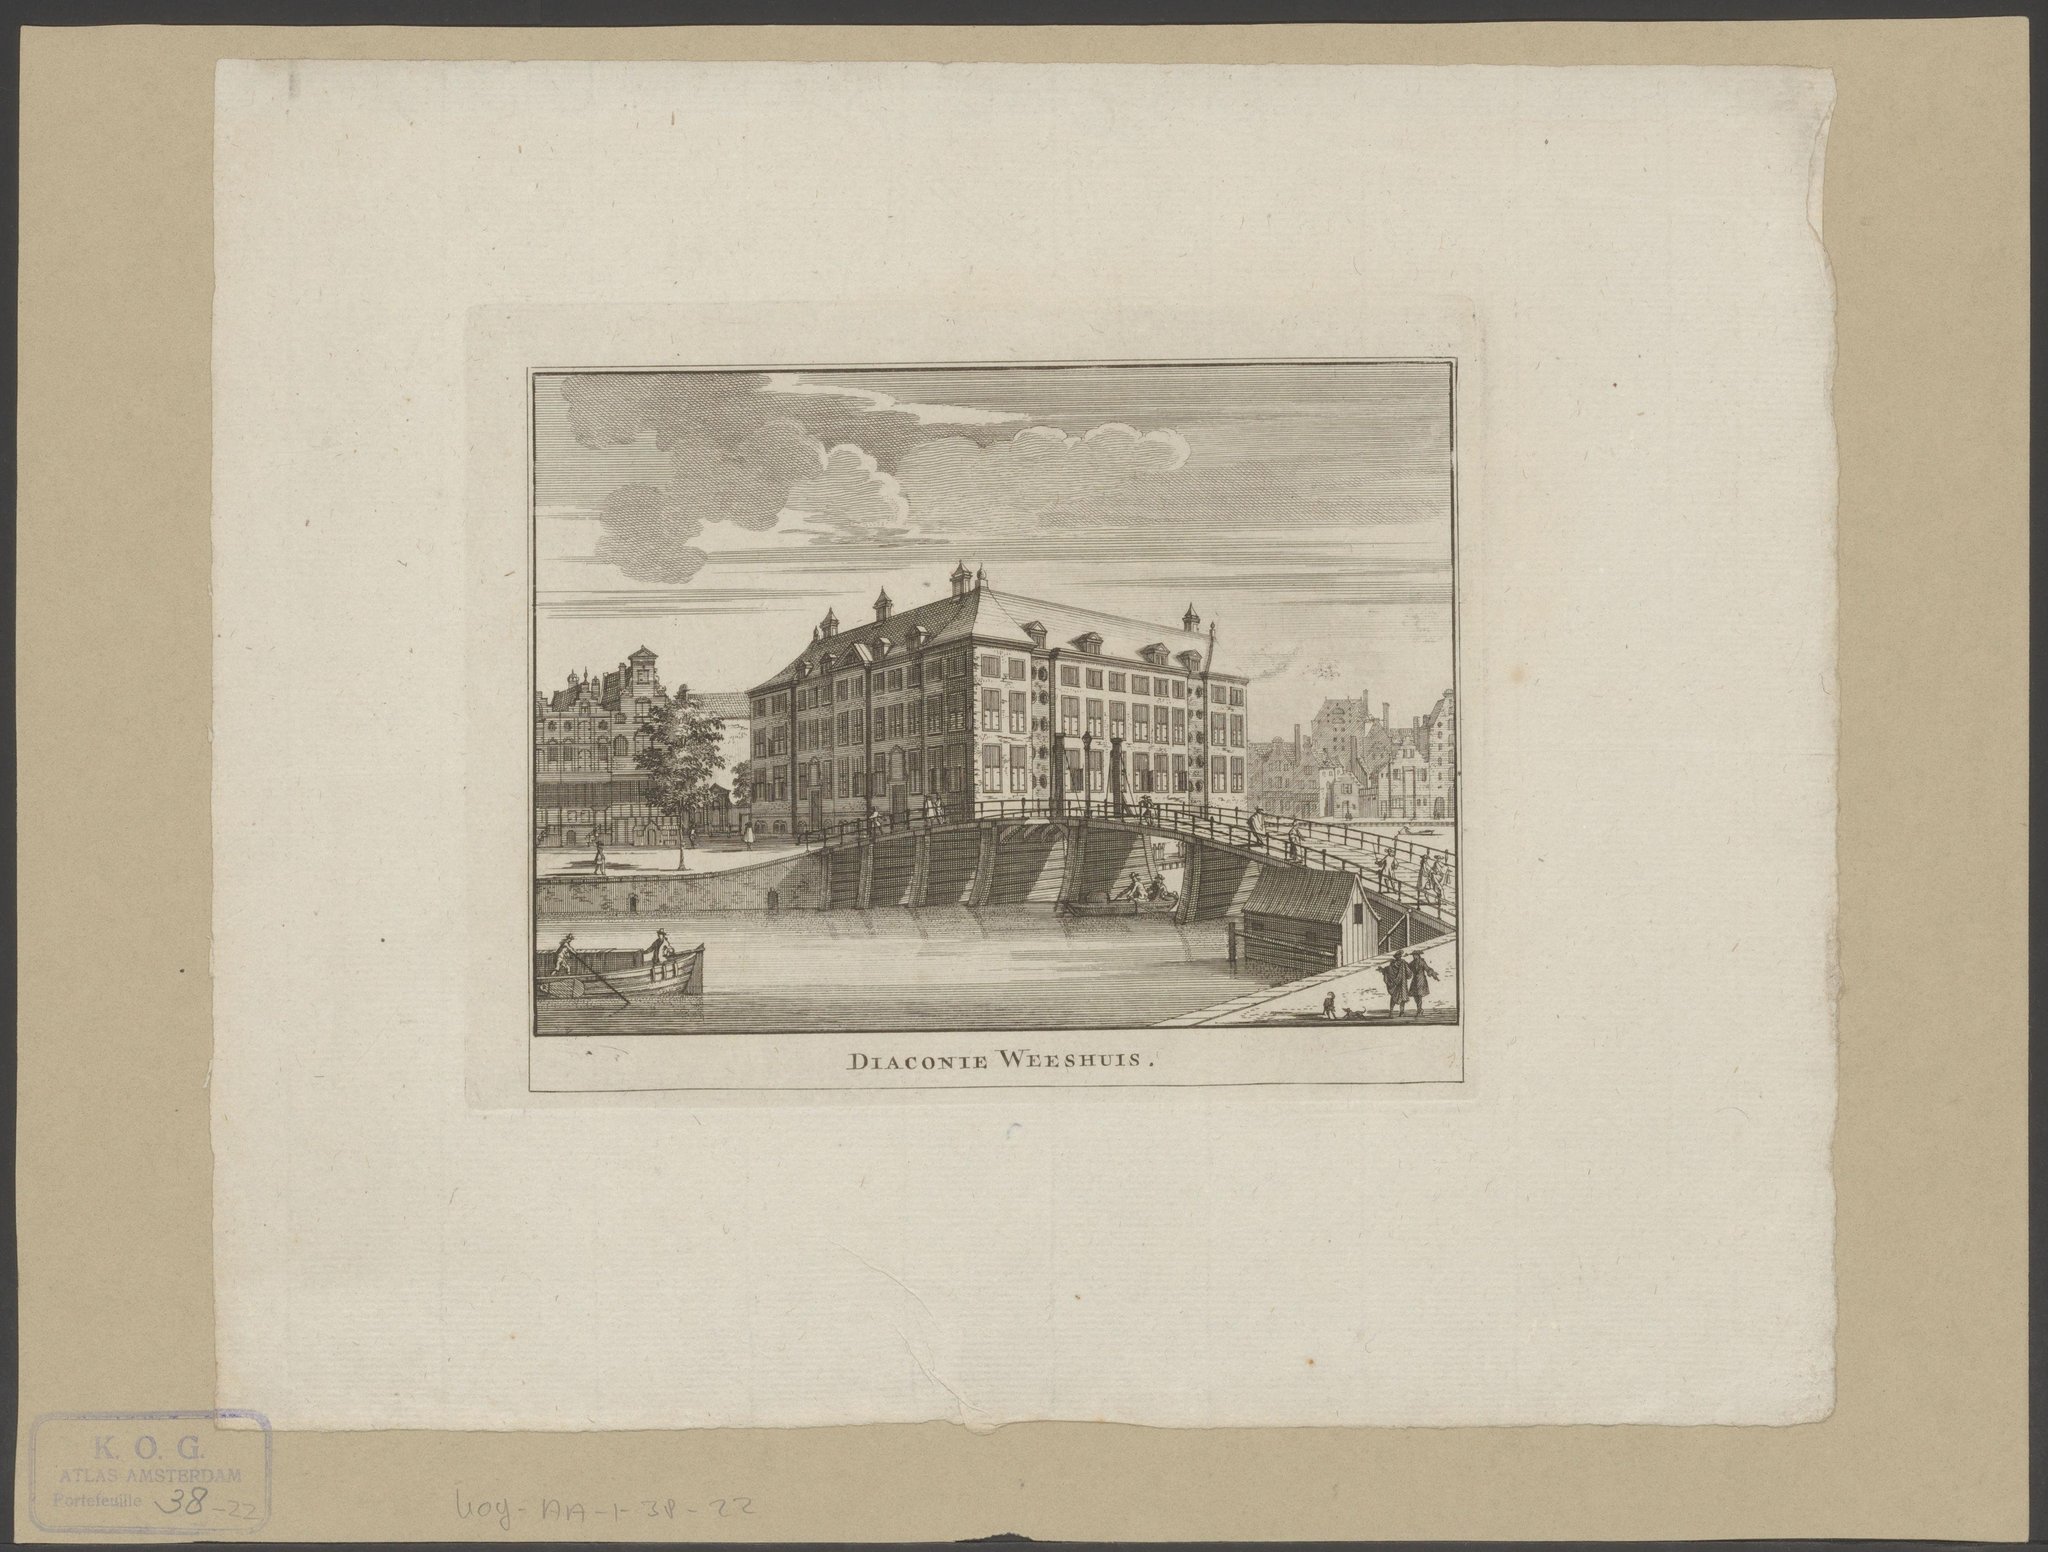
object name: print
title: Diaconie Weeshuis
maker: Anonymous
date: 1751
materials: paper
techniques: engraving, etching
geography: northern netherlands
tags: bridge in city across river, canal, etc. (+ city(-scape) with figures, staffage), orphanage, canals, waters (in city) (+ city(-scape) with figures, staffage)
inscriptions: collector's mark: Lugt 1641b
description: Eerste staat van prent, genummerd 244, gebruikt in: Hoorn, Nicolaas ten. Wegwyzer door Amsterdam zynde eene beknopte verhandeling van desselfs eerste opkomst, vergrootingen, en teegenwoordigen staat (...). Amsterdam: Nicolaas ten Hoorn, 1713. En in: Hoorn, Nicolaas ten. Wegwyzer door Amsterdam zynde eene beknopte verhandeling van desselfs eerste opkomst, vergrootingen, en teegenwoordigen staat (...). Amsterdam: Nicolaas ten Hoorn, 1726. Tweede staat van prent, genummerd 259, gebruikt in: Hoorn, Nicolaas ten. Wegwyzer door Amsterdam zynde eene beknopte verhandeling van desselfs eerste opkomst, vergrootingen, en teegenwoordigen staat (...). Amsterdam: Nicolaas ten Hoorn, 1726. En in: Hoorn, Nicolaas ten. Wegwyzer, of korte beschryvinge van de stadt Amsterdam, zynde eene beknopte verhandeling van desselfs eerste opkomst, vergrootingen, en teegenwoordigen staat (...). Amsterdam: erven J. Ratelband & Co, 1737. En in: Hoorn, Nicolaas ten. Wegwyzer of korte beschryvinge der stad Amsterdam, zynde eene beknopte verhandeling van derzelver eerste opkomst, vergrootingen, en tegenwoordigen staat (...). Amsterdam: Pieter Meyer, 1751.